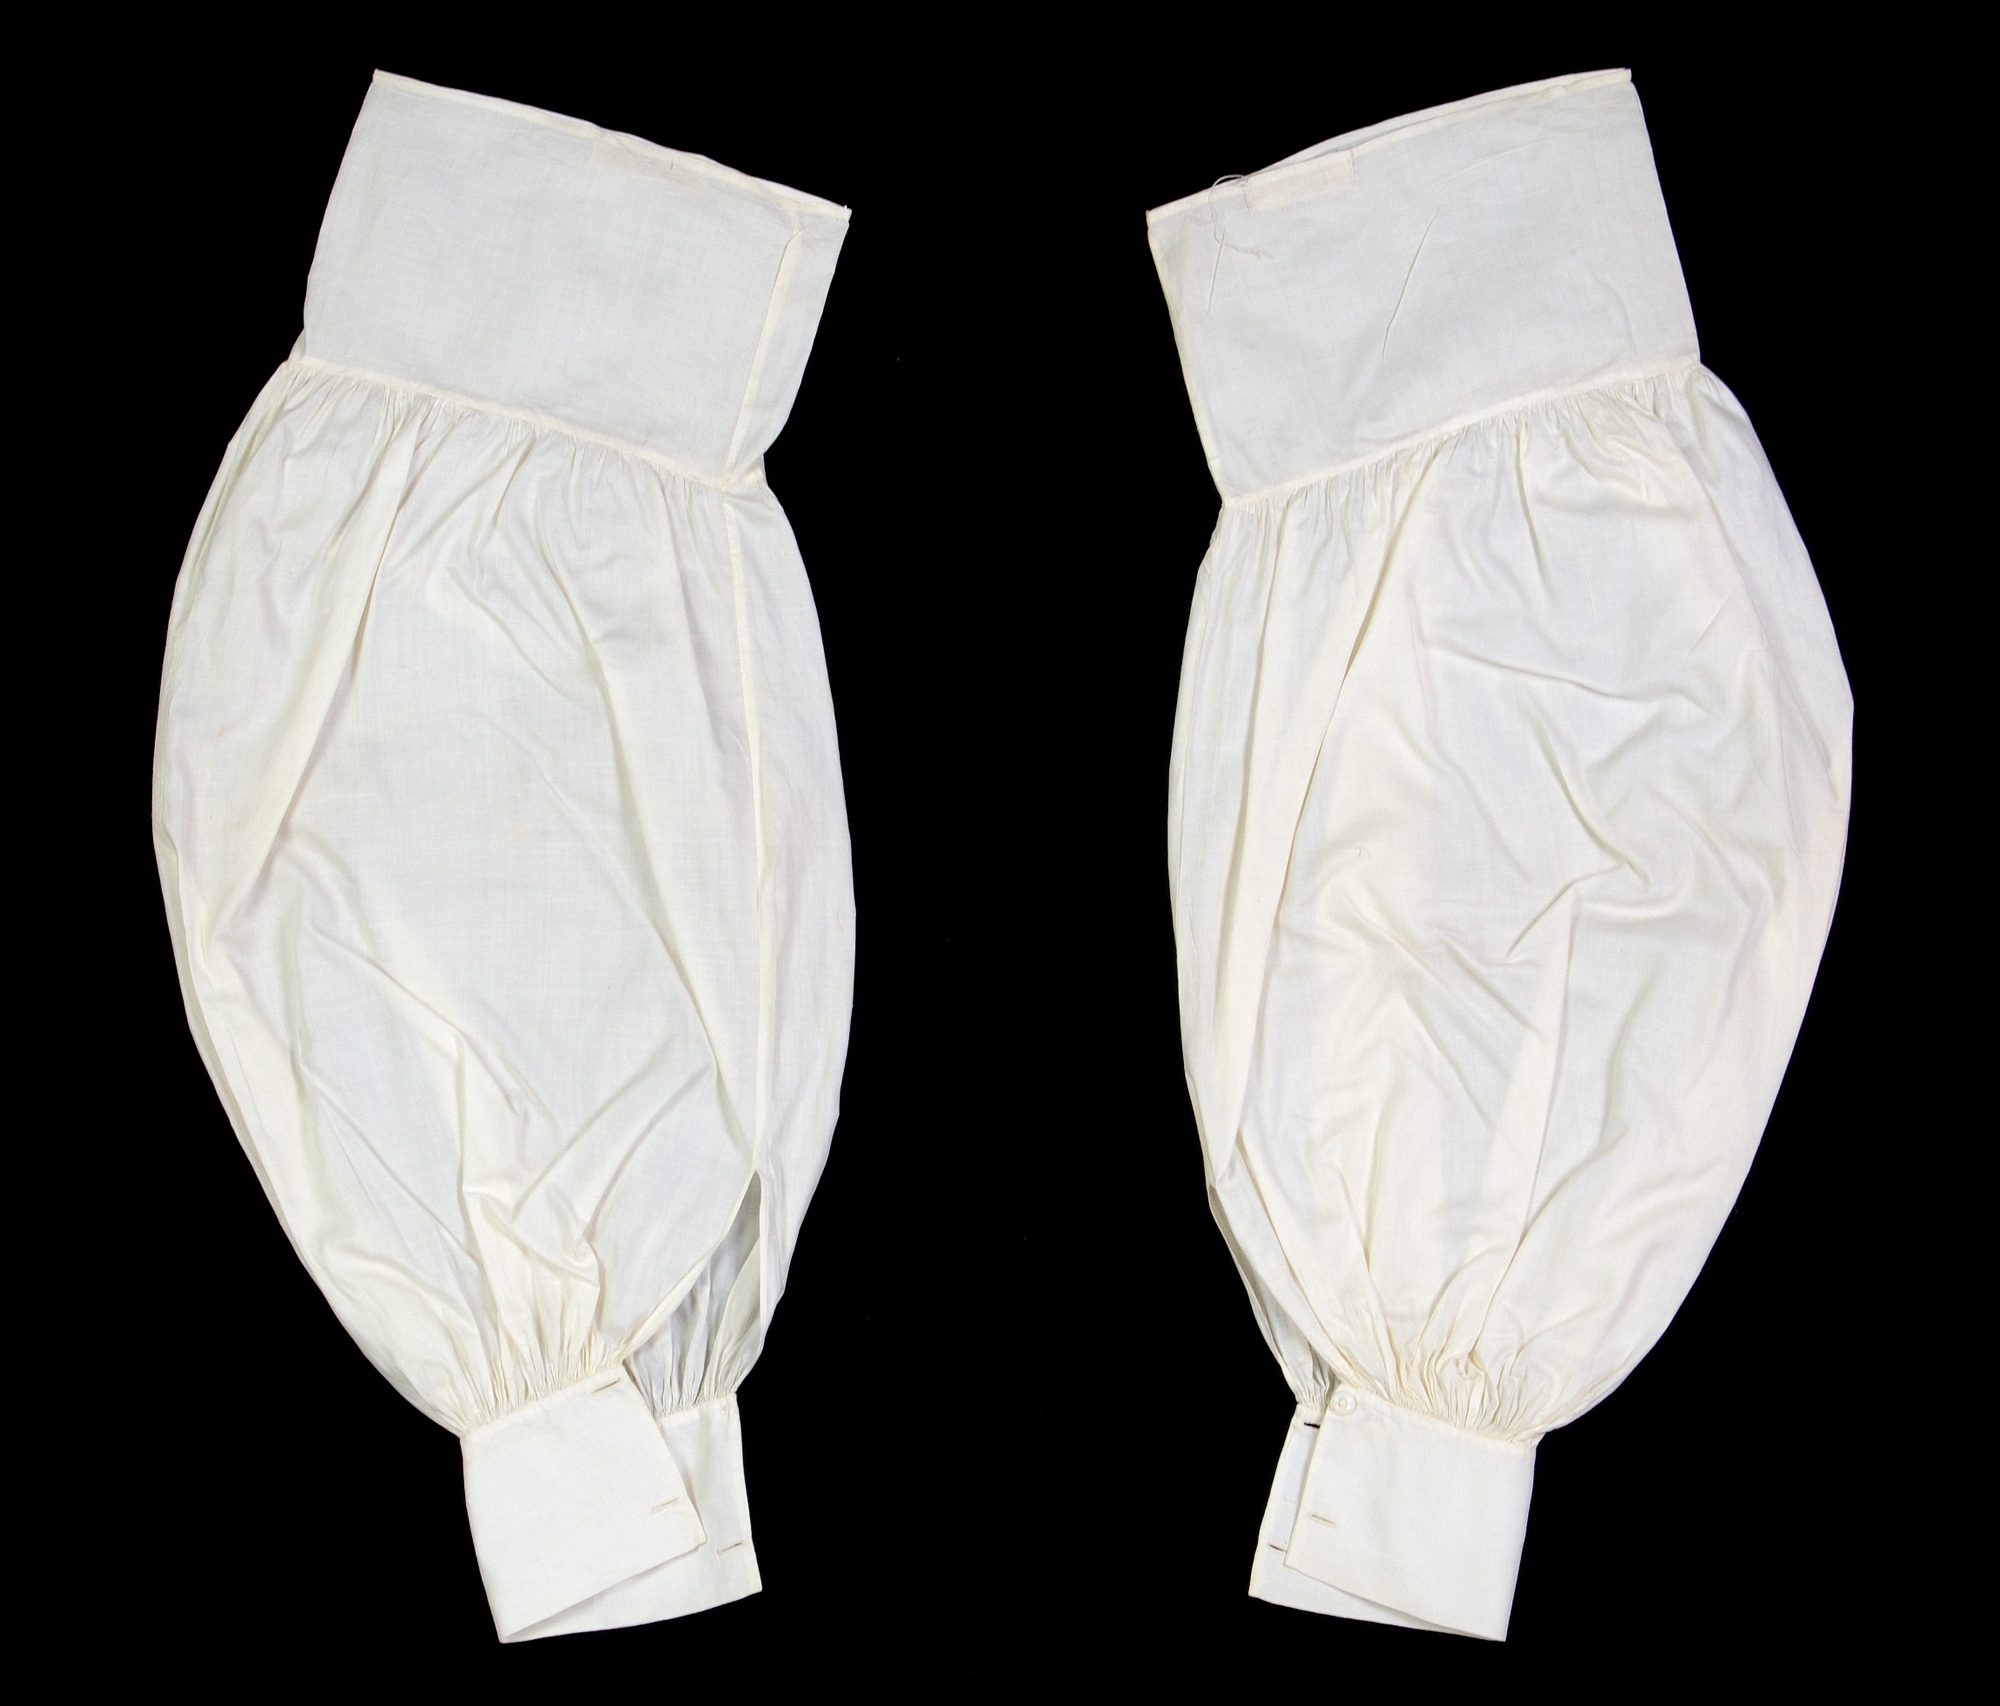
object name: undersleeves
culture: american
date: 1860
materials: linen